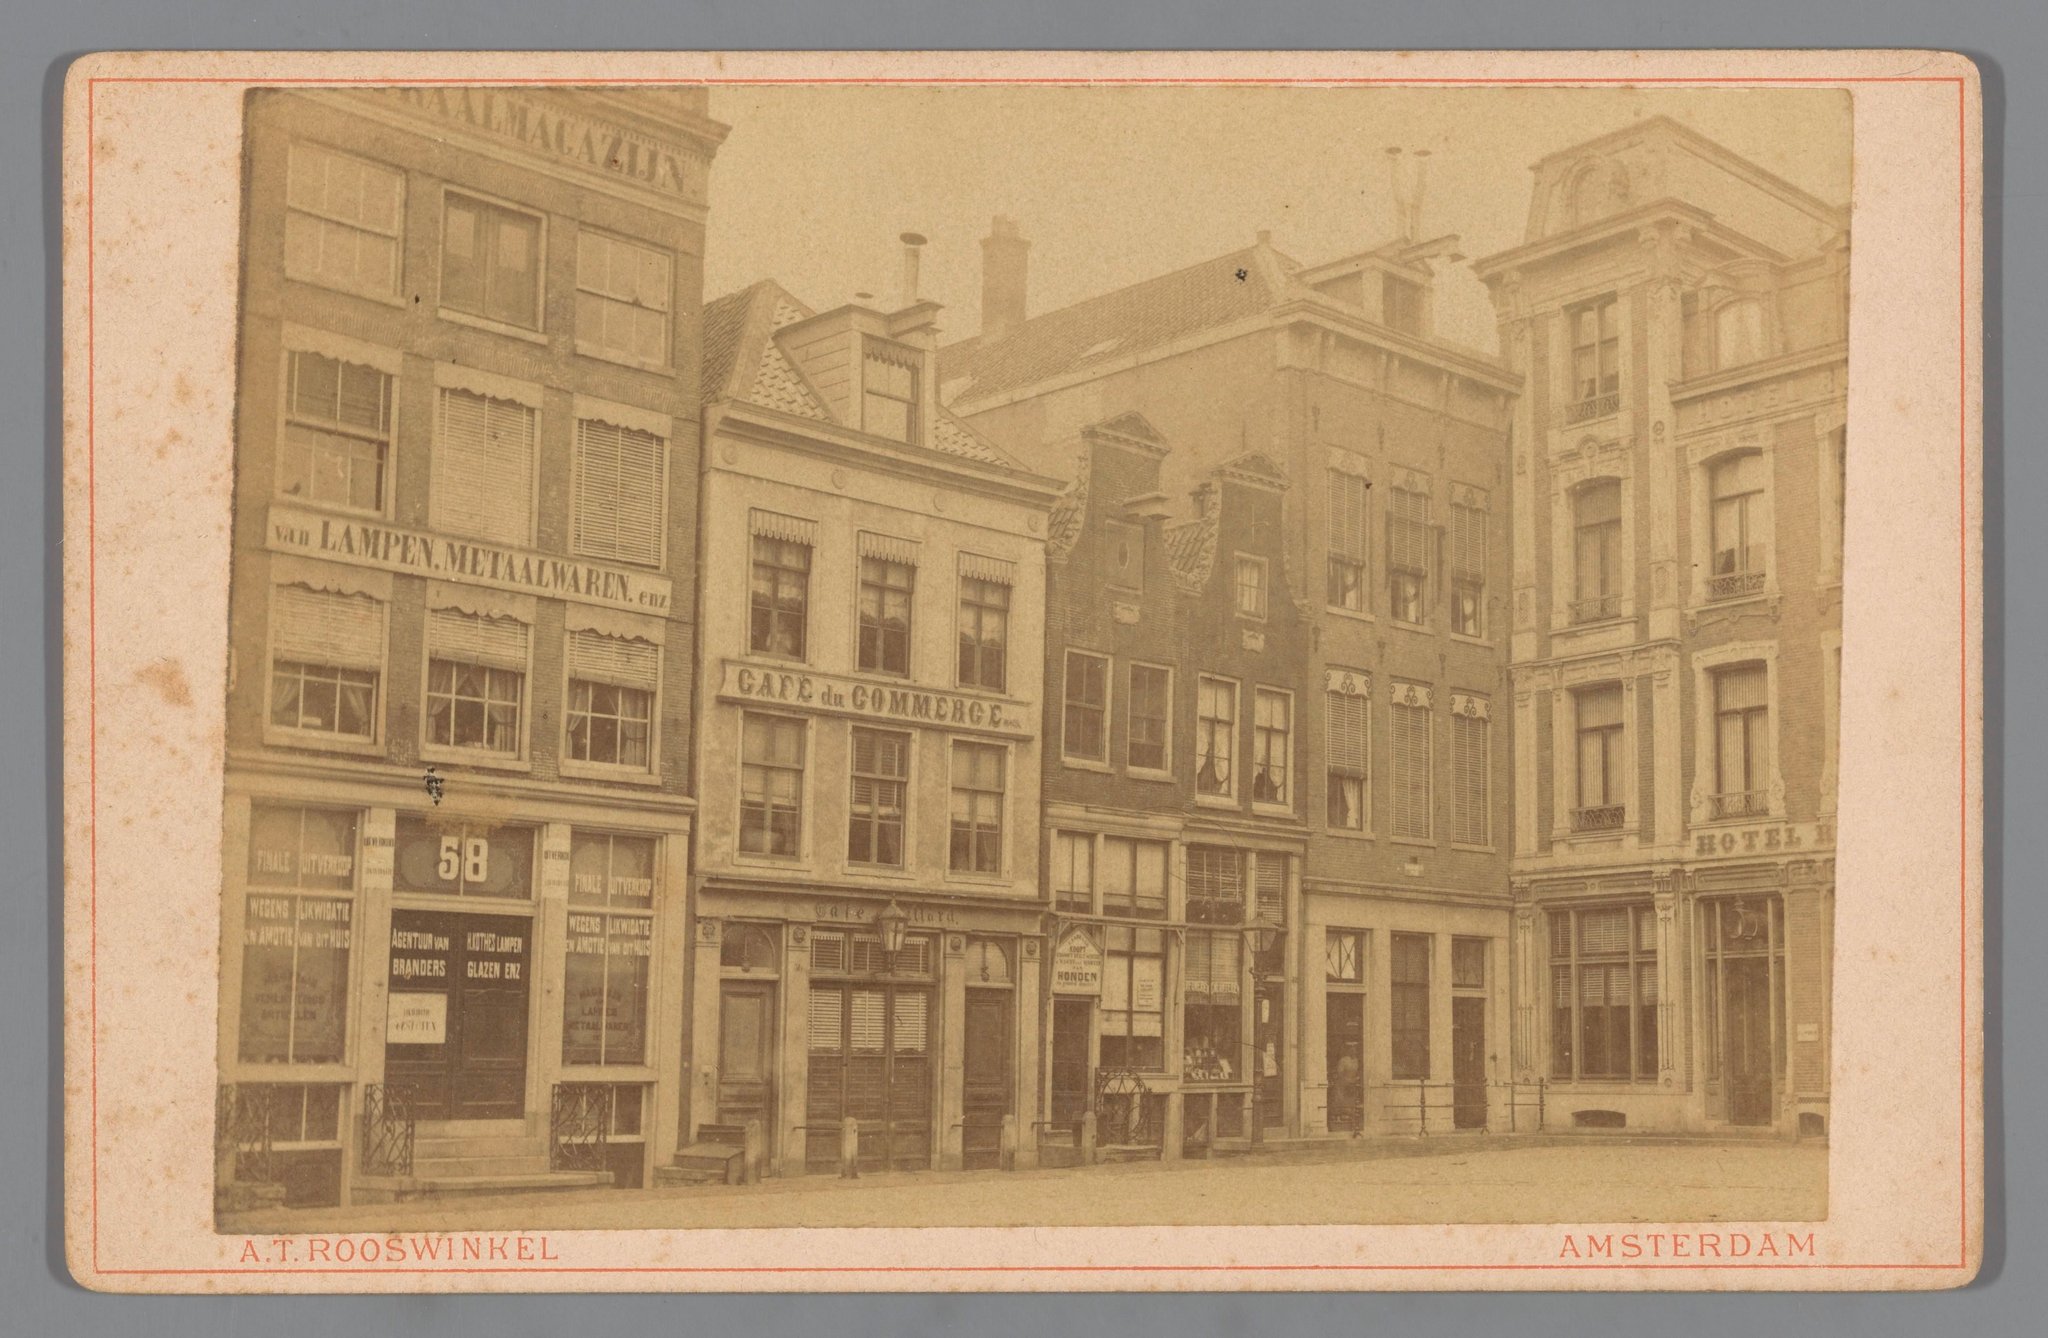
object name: cabinet photograph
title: Gezicht op de Kippenhoek, later Rembrandtplein, te Amsterdam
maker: andreas theodorus rooswinkel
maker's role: fotograaf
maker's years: 1838-1909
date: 1868-1875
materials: cardboard, photographic support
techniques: albumen print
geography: amsterdam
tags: square, place, circus, etc.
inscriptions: annotation: ‘Kippenhoek’, retailer's mark: ‘GEBR. DOUWES./ ATELIER/ Grimburgwal 15/ AMSTERDAM.’, annotation: ‘de "Kippenhoek" (Rembrandtplein)’